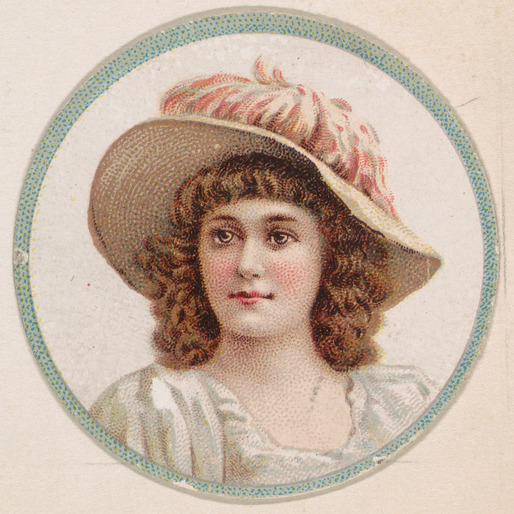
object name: print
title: Woman wearing feathered hat, from the Novelties series (N228, Type 2) issued by Kinney Bros.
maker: kinney brothers tobacco company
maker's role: publisher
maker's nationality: american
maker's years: 1869-2011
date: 1889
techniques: color lithograph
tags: women